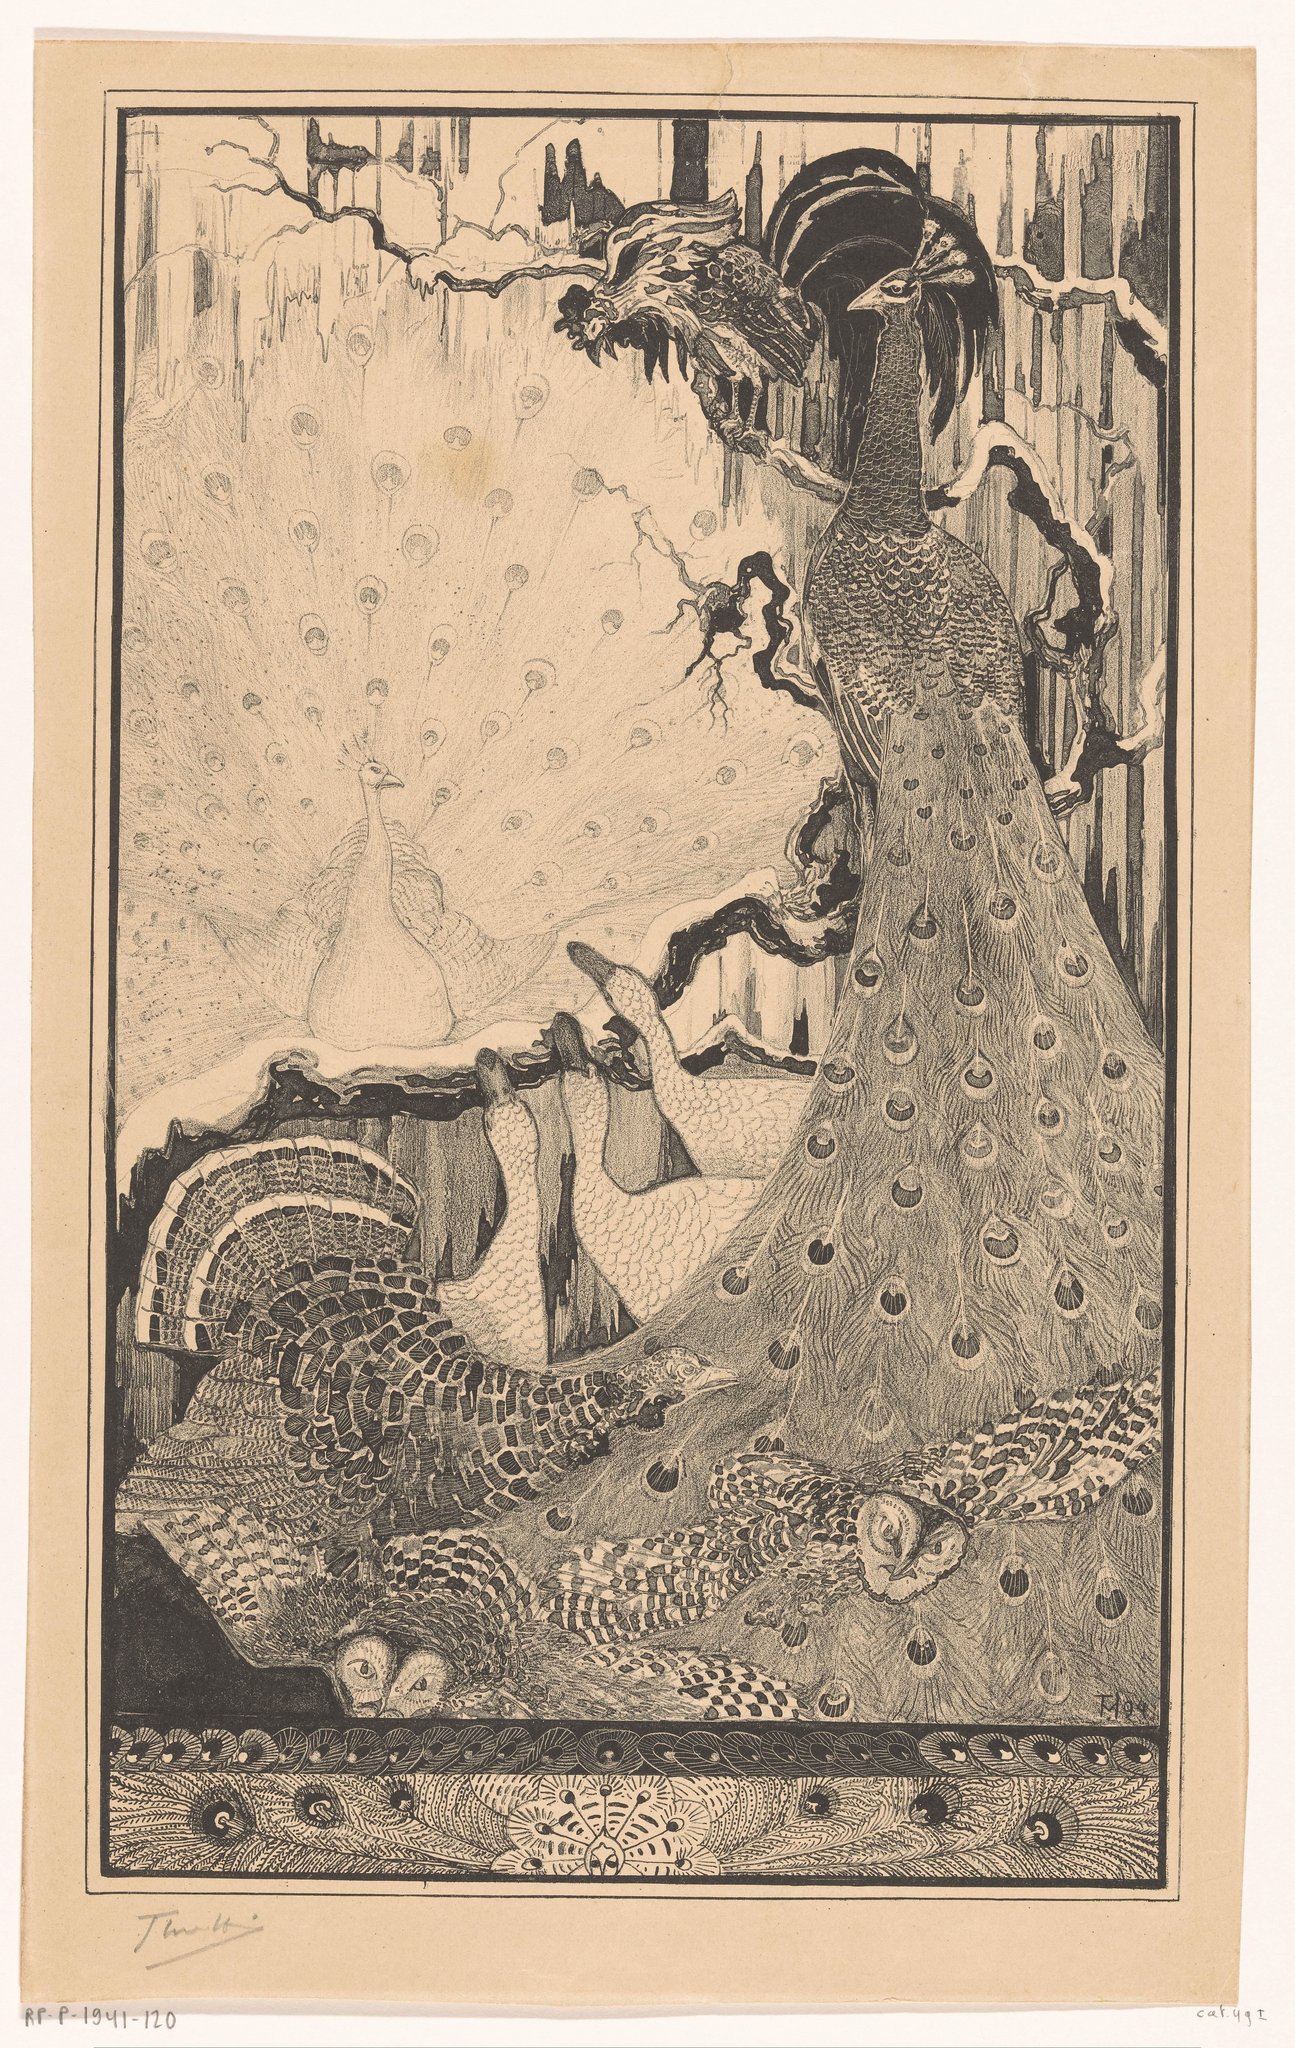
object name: print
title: Nieuwjaar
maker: theo van hoytema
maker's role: draughtsman, painter, print maker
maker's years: 1863-1917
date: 1894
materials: paper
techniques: lithograph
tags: birds, new year's eve (december 31)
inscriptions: collector's mark: Lugt 2760, collector's mark: Lugt 2228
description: Een donkere pauw, een symbool voor het oude jaar, bekijkt een lichtere pauw, symbool voor het nieuwe jaar. Op de voorgrond twee uilen en een korhoen. Op de achtergrond drie ganzen en een haan.